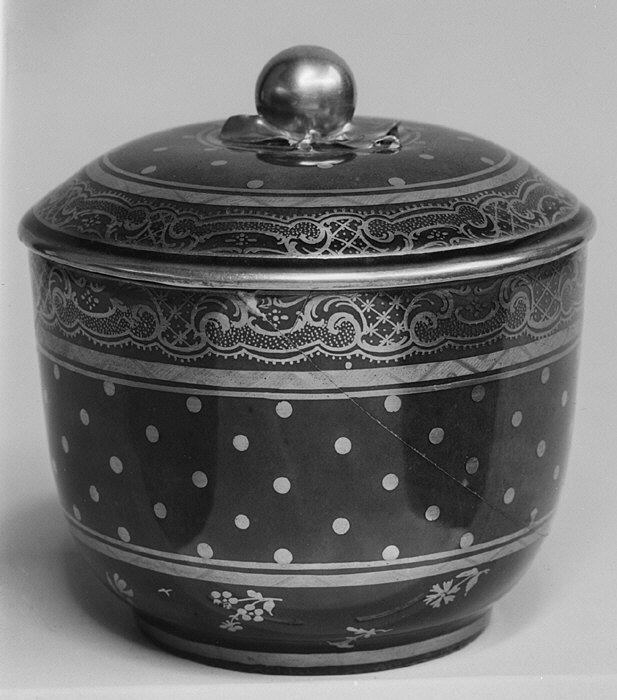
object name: sugar bowl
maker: sèvres manufactory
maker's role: manufactory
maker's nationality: french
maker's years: 1740-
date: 1701-1800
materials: soft paste porcelain